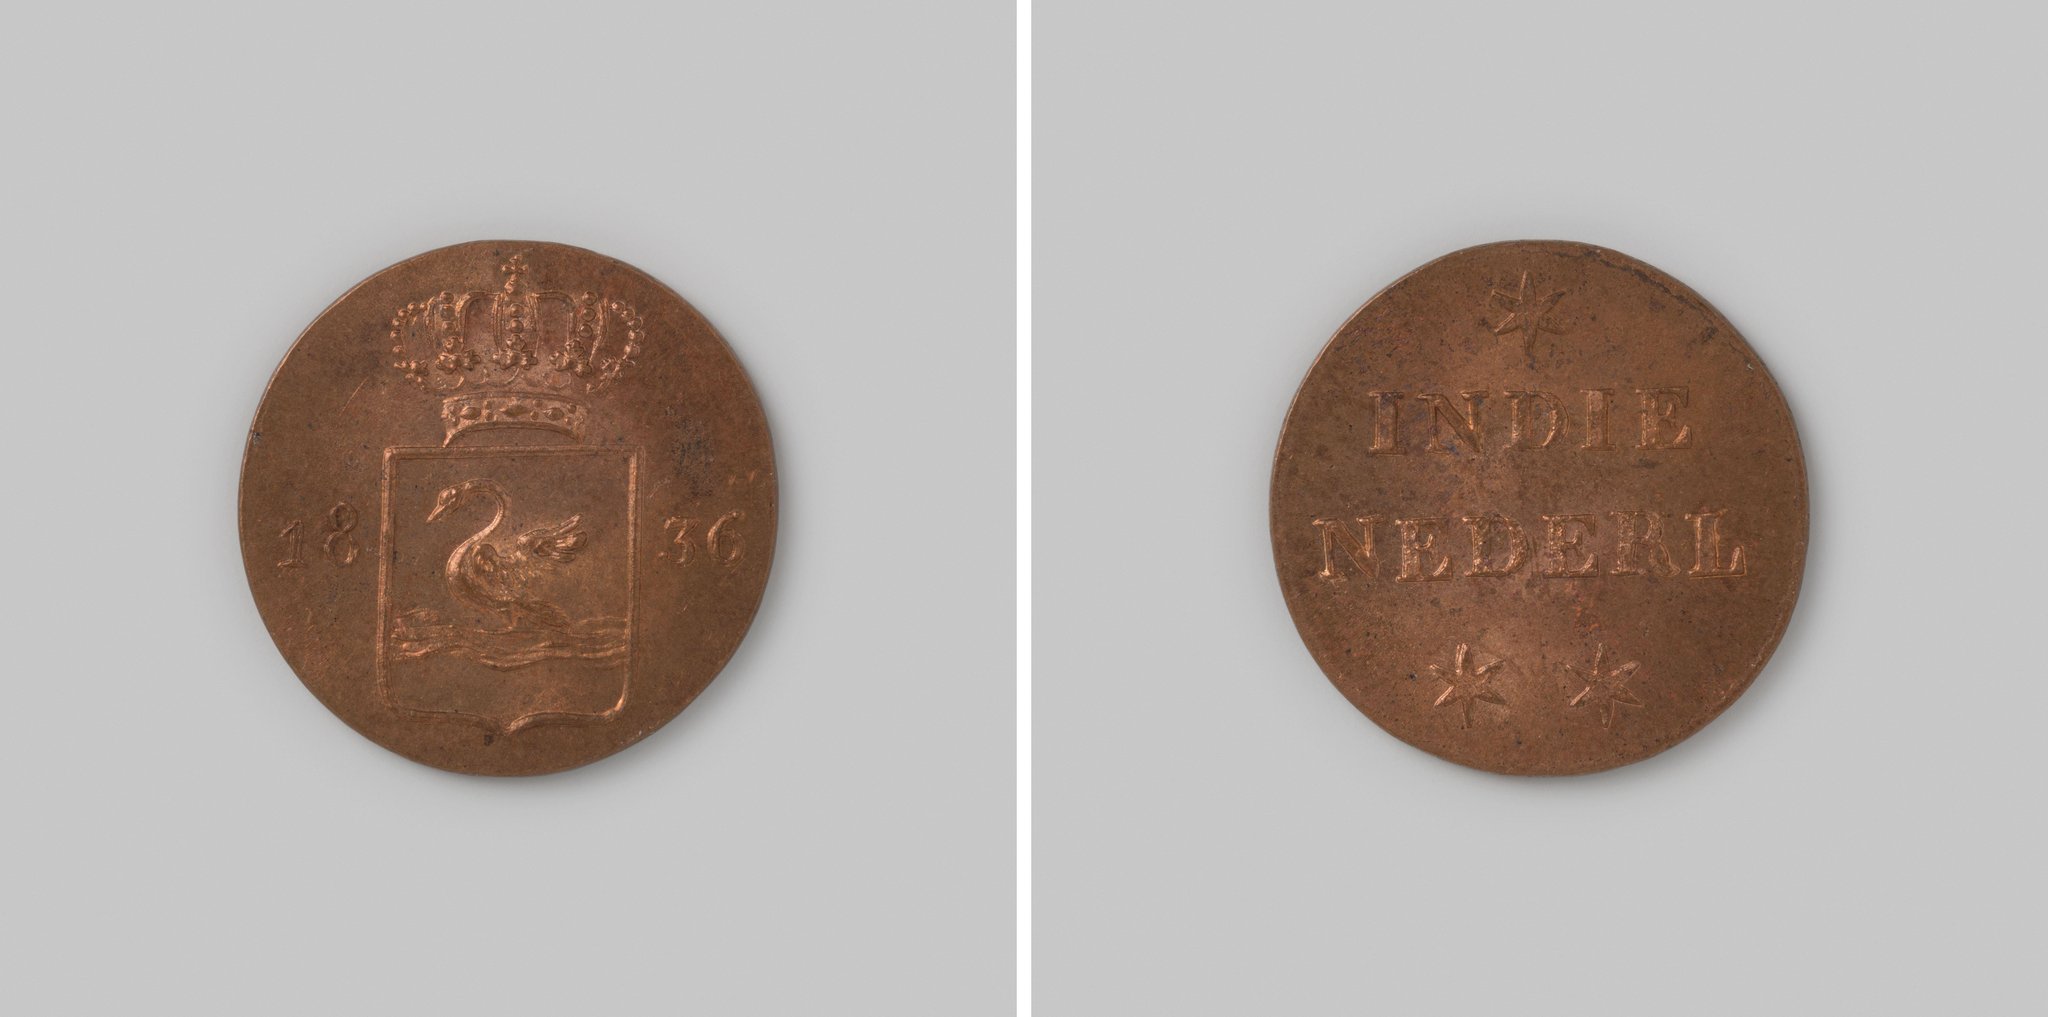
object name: coin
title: Nederlands Indië, zwaantjesduit,1836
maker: Anonymous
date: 1836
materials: copper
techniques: striking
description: Koperen proefmunt. Voorzijde: tussen jaartal gekroond wapenschild, waarin zwaan. Keerzijde: tweeregelig opschrift: INDIE NEDERL, waarboven een ster en waaronder twee sterren. Gladde rand.